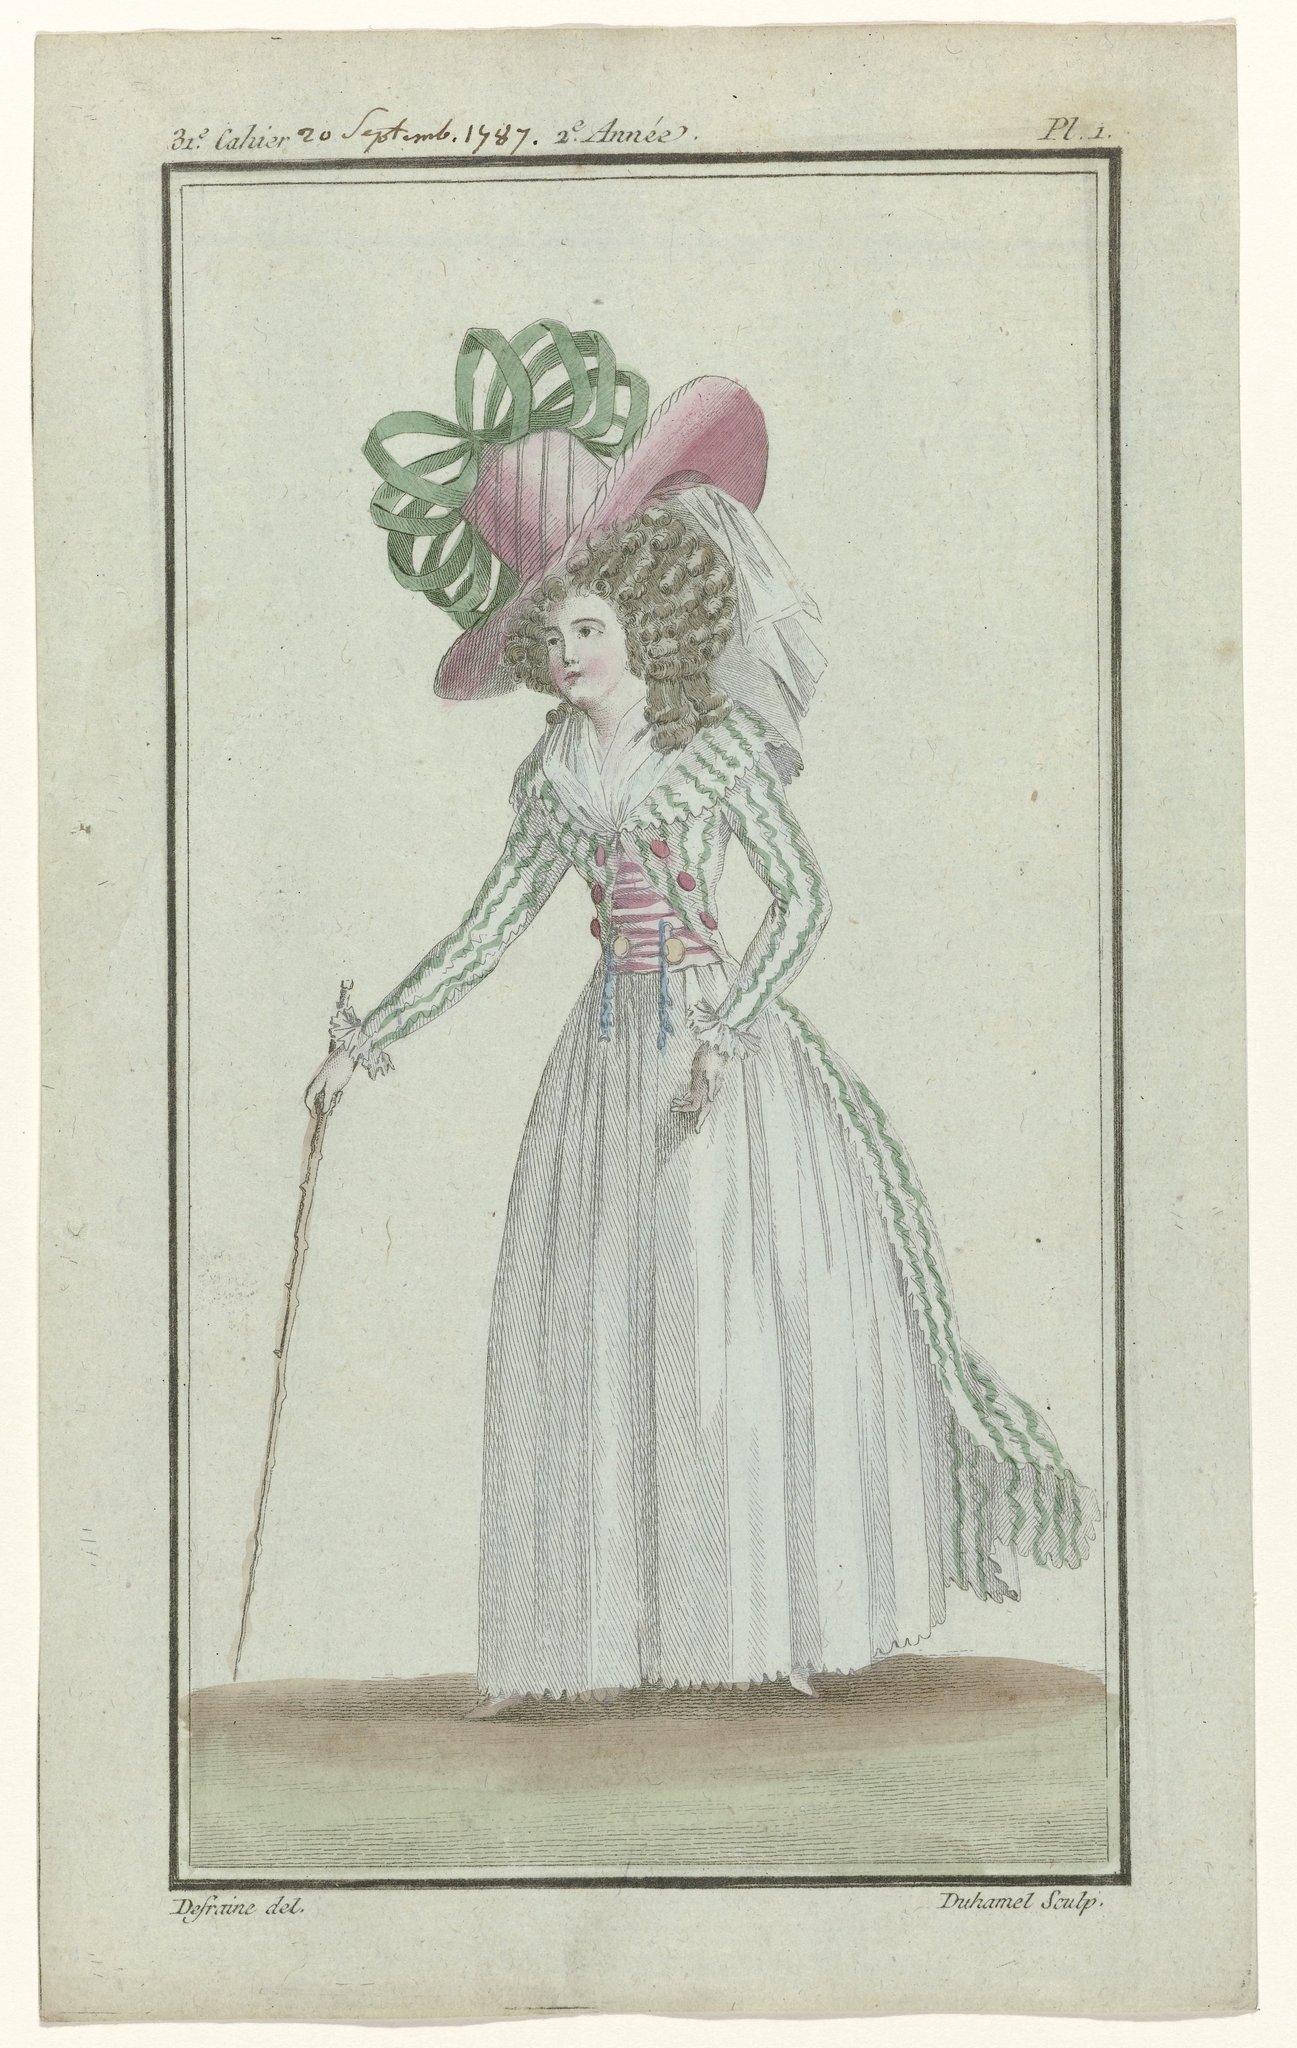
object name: fashion print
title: Magasin des Modes Nouvelles Françaises et Anglaises, 20 septembre 1787, Pl. 1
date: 1787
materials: paper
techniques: engraving, hand coloring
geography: paris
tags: clothing for the upper part of the body (+ women's clothes), walking-stick, staff, cane (+ women's clothes), dress, gown: redingote (+ women's clothes), head-gear (+ women's clothes), fashion plates, skirt (+ women's clothes), piece of clothing covering the breast or décolleté (fichu) (+ women's clothes)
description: Staande vrouw gekleed in een gestreepte redingote met geschulpte zoom. Zij draagt een fichu van tule, gestreept lijfje en een rok met geschulpte zoom. Gerimpelde manchetten. Accessoires: grote gestreepte hoed met lint en sluier(?), wandelstok van bamboe, chatelaines(?). De prent maakt deel uit van het 31e Cahier, 2e année, uit de serie Magasin des Modes Nouvelles Françaises et Anglaises. De serie bestaat uit 172 modeprenten, uitgegeven door Buisson, Parijs, 20 novembre 1786 - 21 décembre 1789.